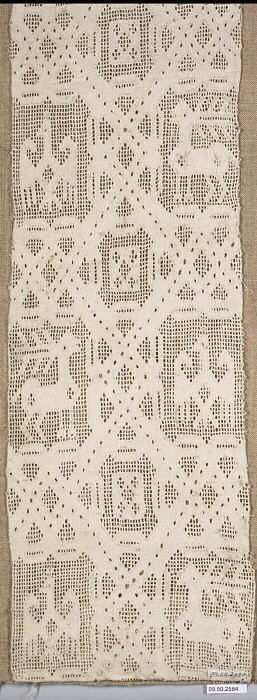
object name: fragment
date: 1501-1700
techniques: embroidery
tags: birds